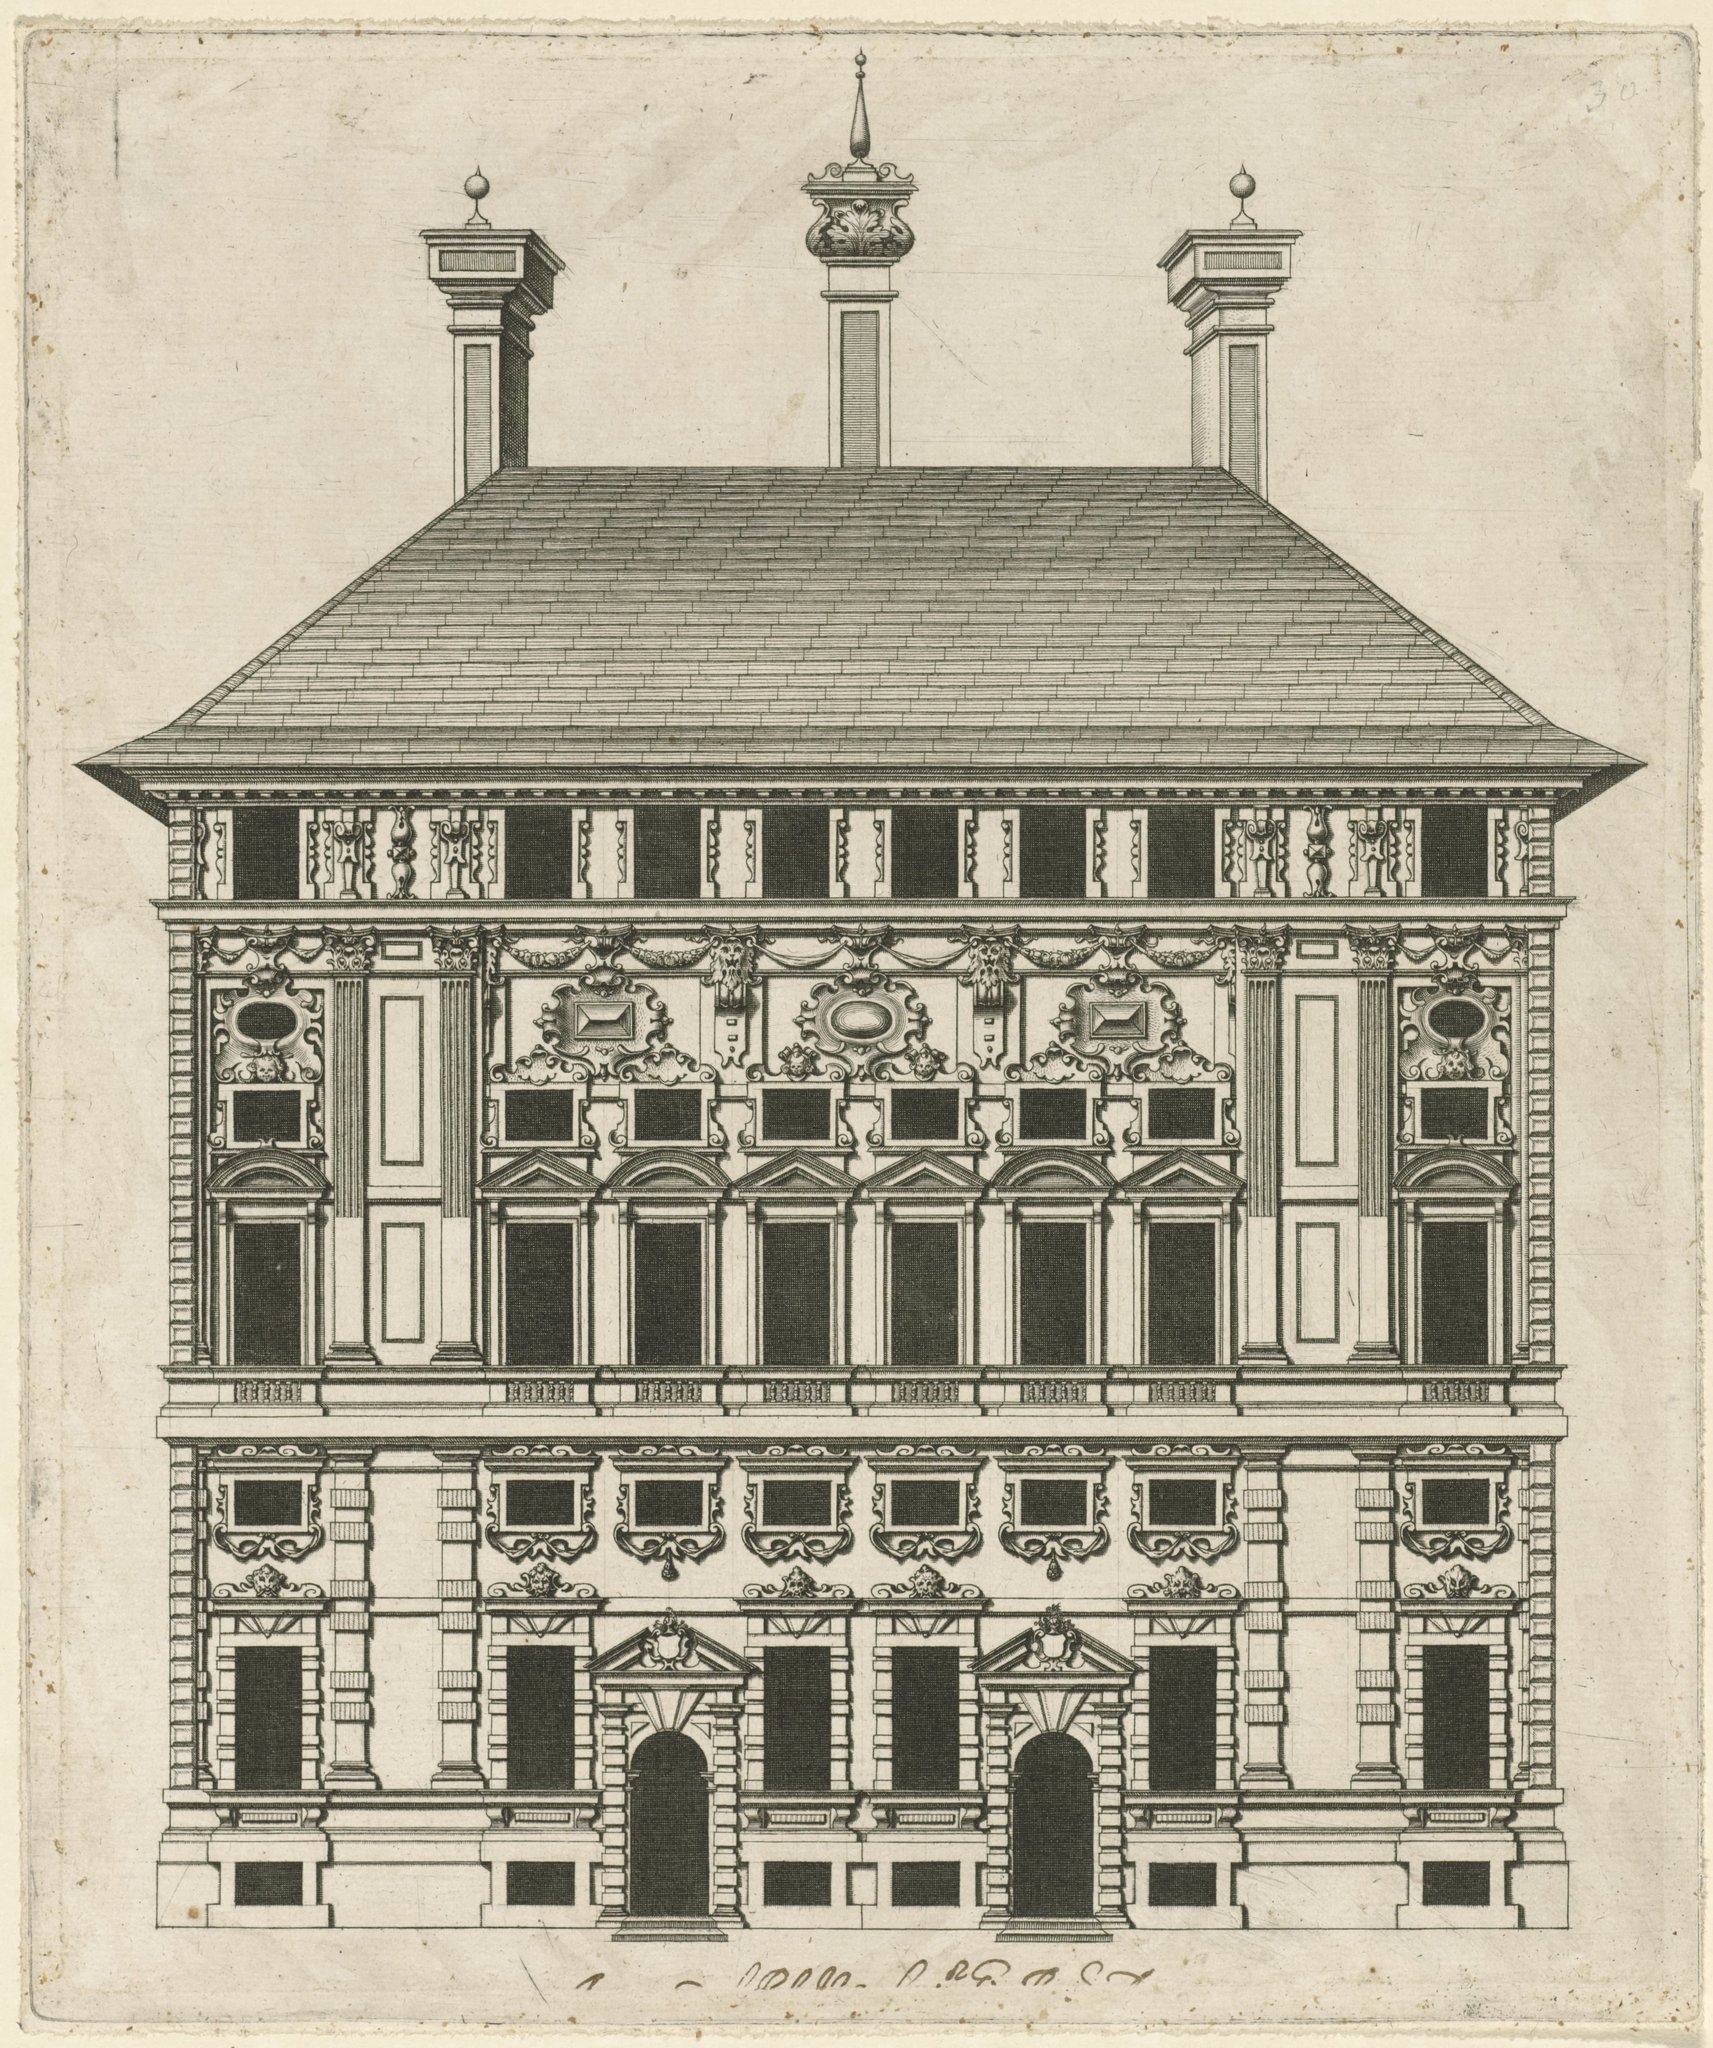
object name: print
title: Palazzo Cattaneo Adorno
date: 1622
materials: paper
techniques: engraving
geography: antwerp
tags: façade (of house or building)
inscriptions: collector's mark: Lugt 240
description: Prent gebruikt in: Peter Paul Rubens, Nicolaes Ryckmans. Palazzi di Genova. 2 dl. G. Meursio: Antwerpen, 1622, nr. 30.